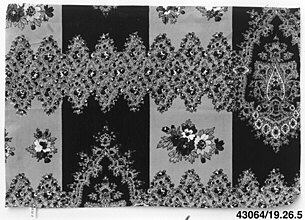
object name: sample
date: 1840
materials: cotton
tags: flowers